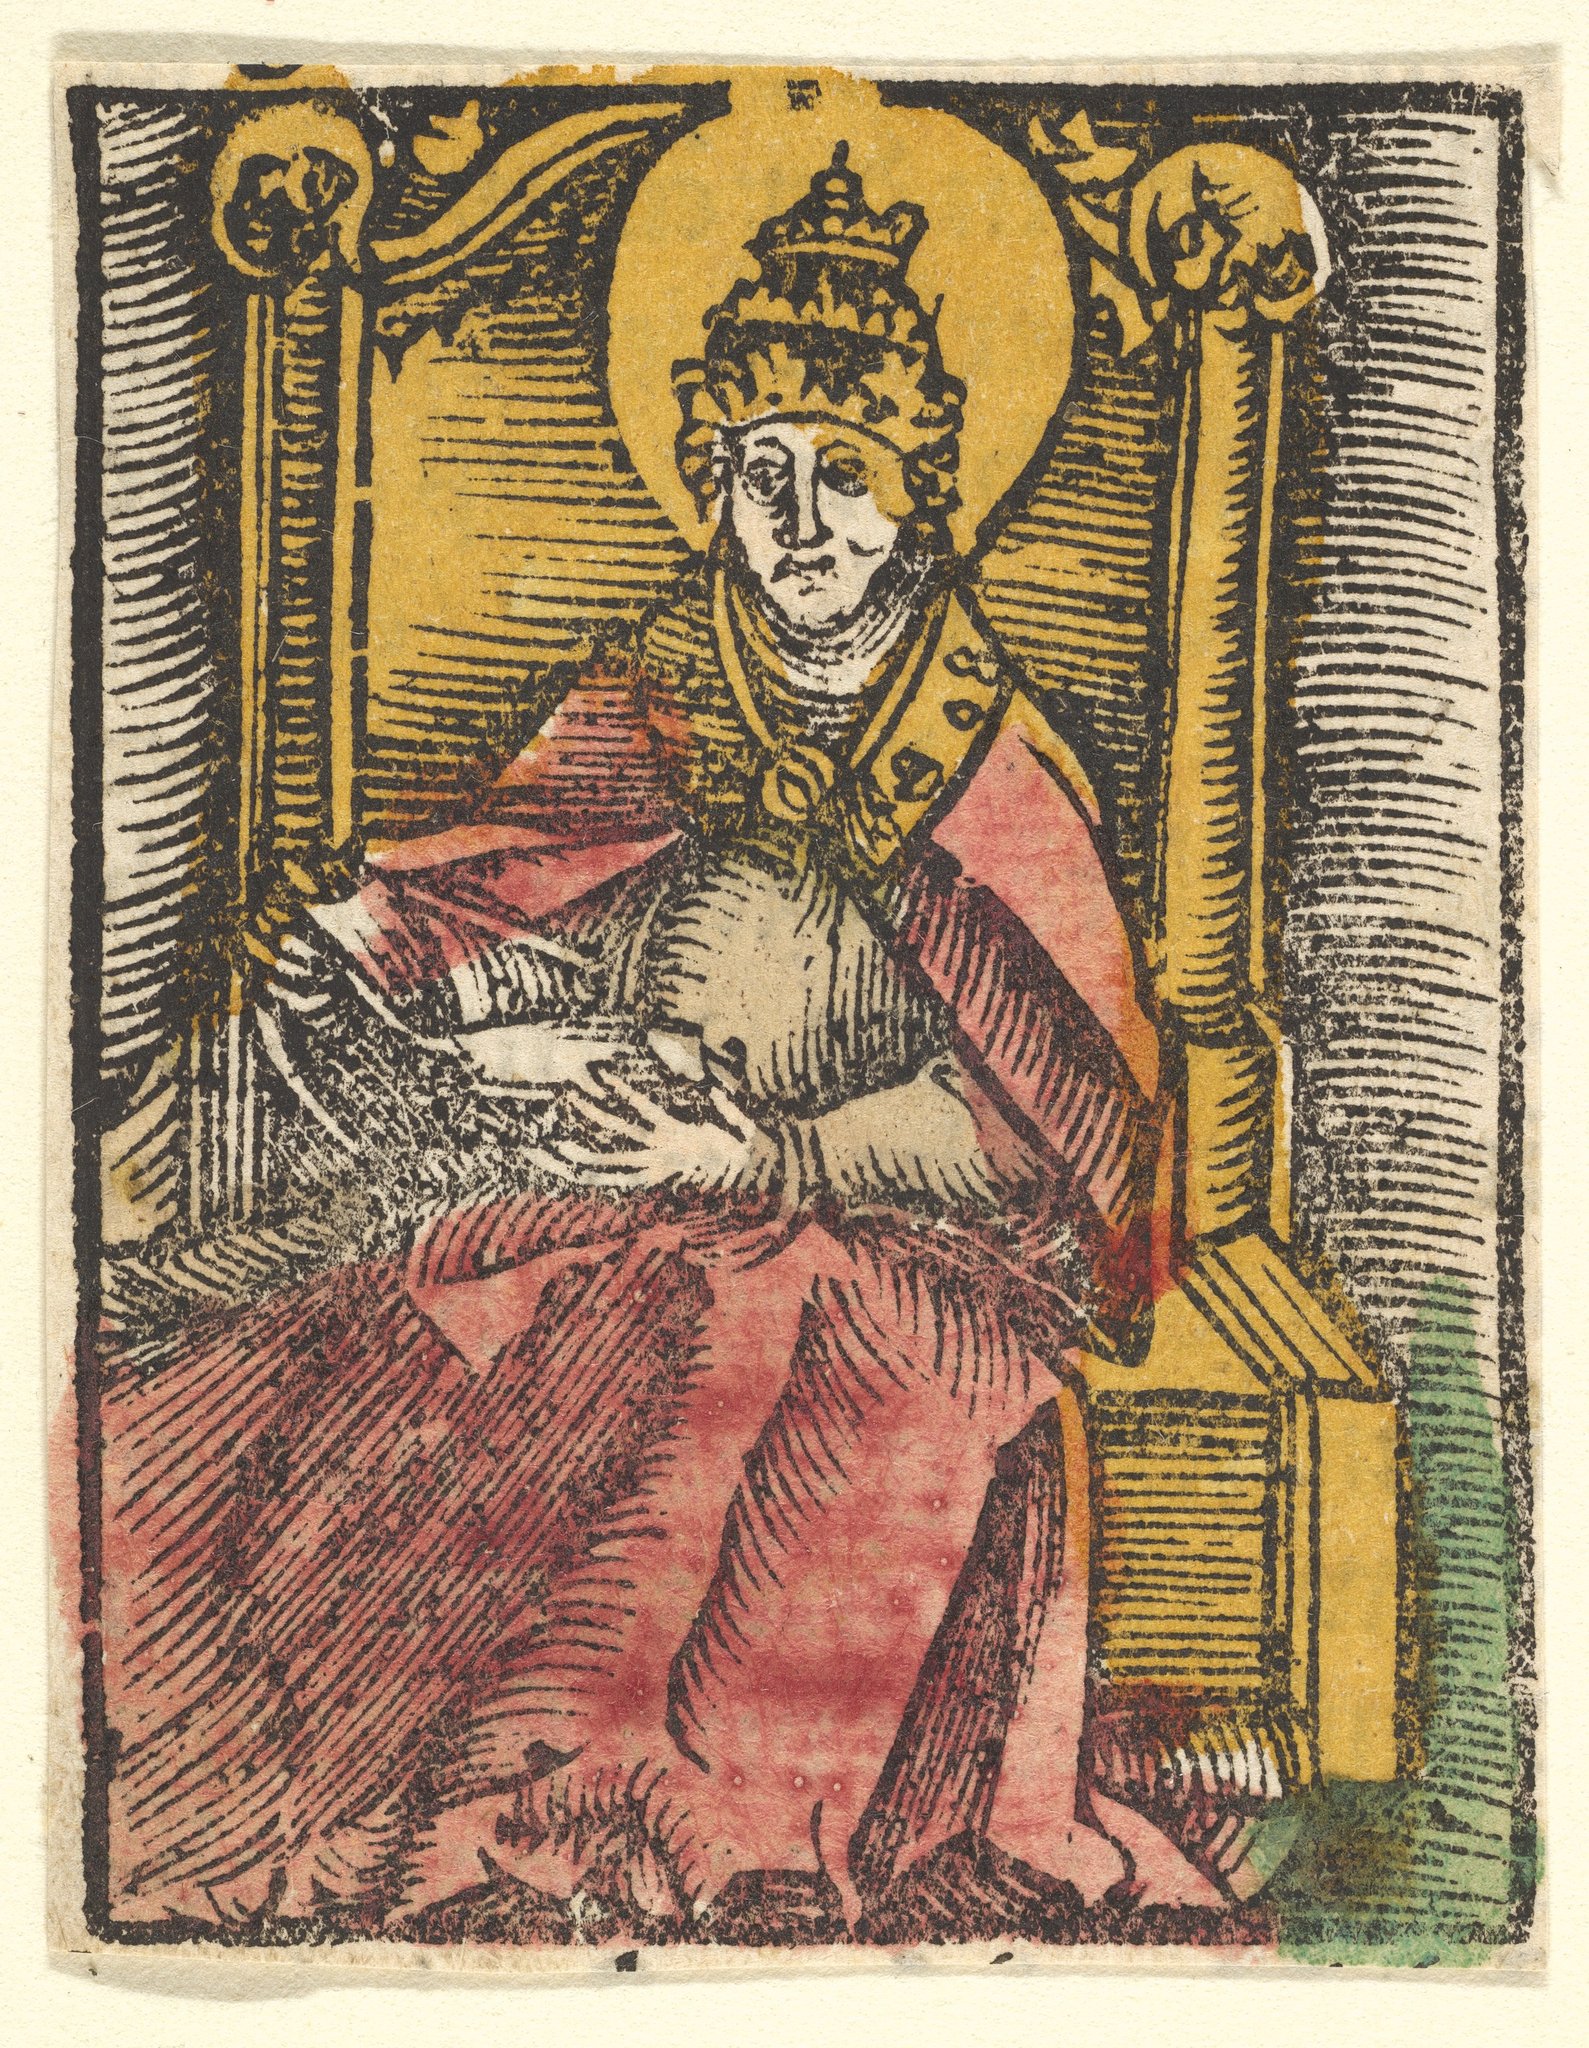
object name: print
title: St. Gregory (copy)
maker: hans baldung (called hans baldung grien)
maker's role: artist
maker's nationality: german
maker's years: 1484-1545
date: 1511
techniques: hand coloring, woodcut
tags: books,men,popes,saints